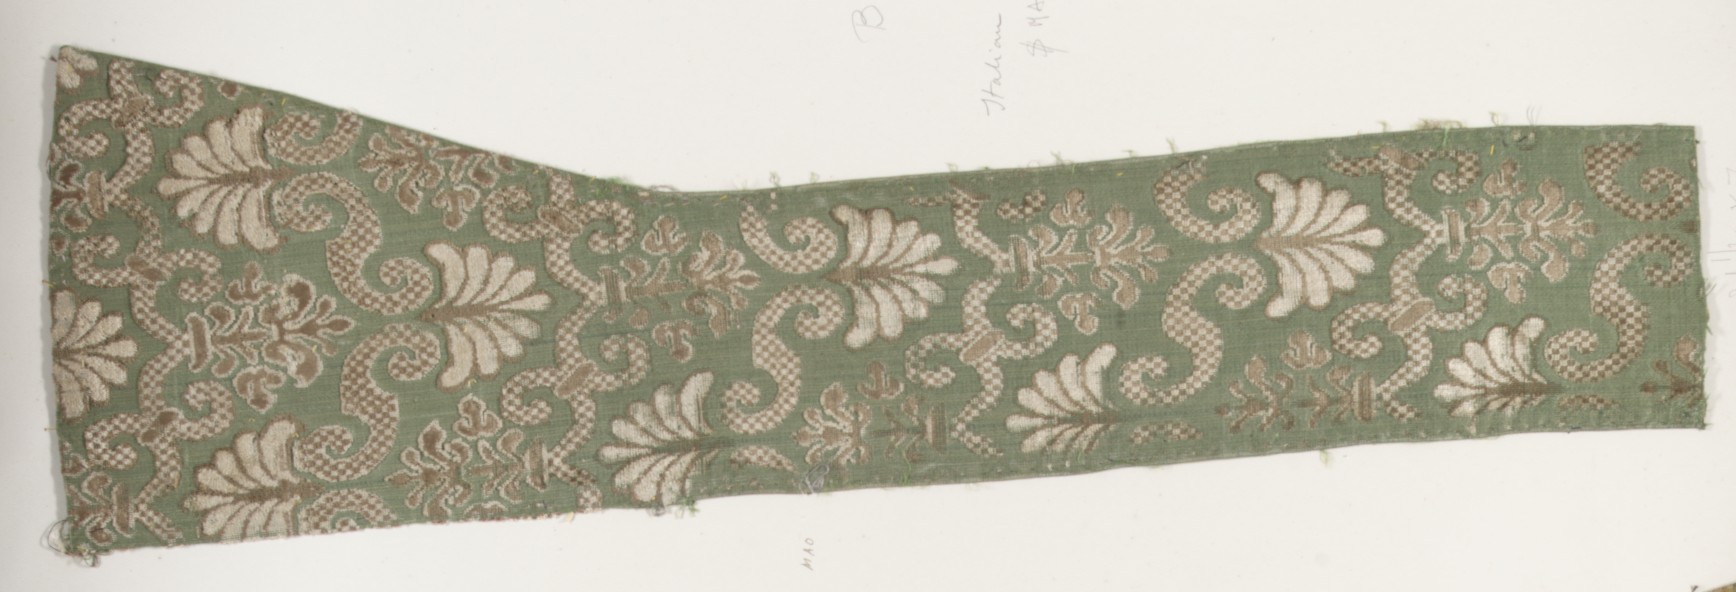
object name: fragment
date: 1567-1600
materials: silk